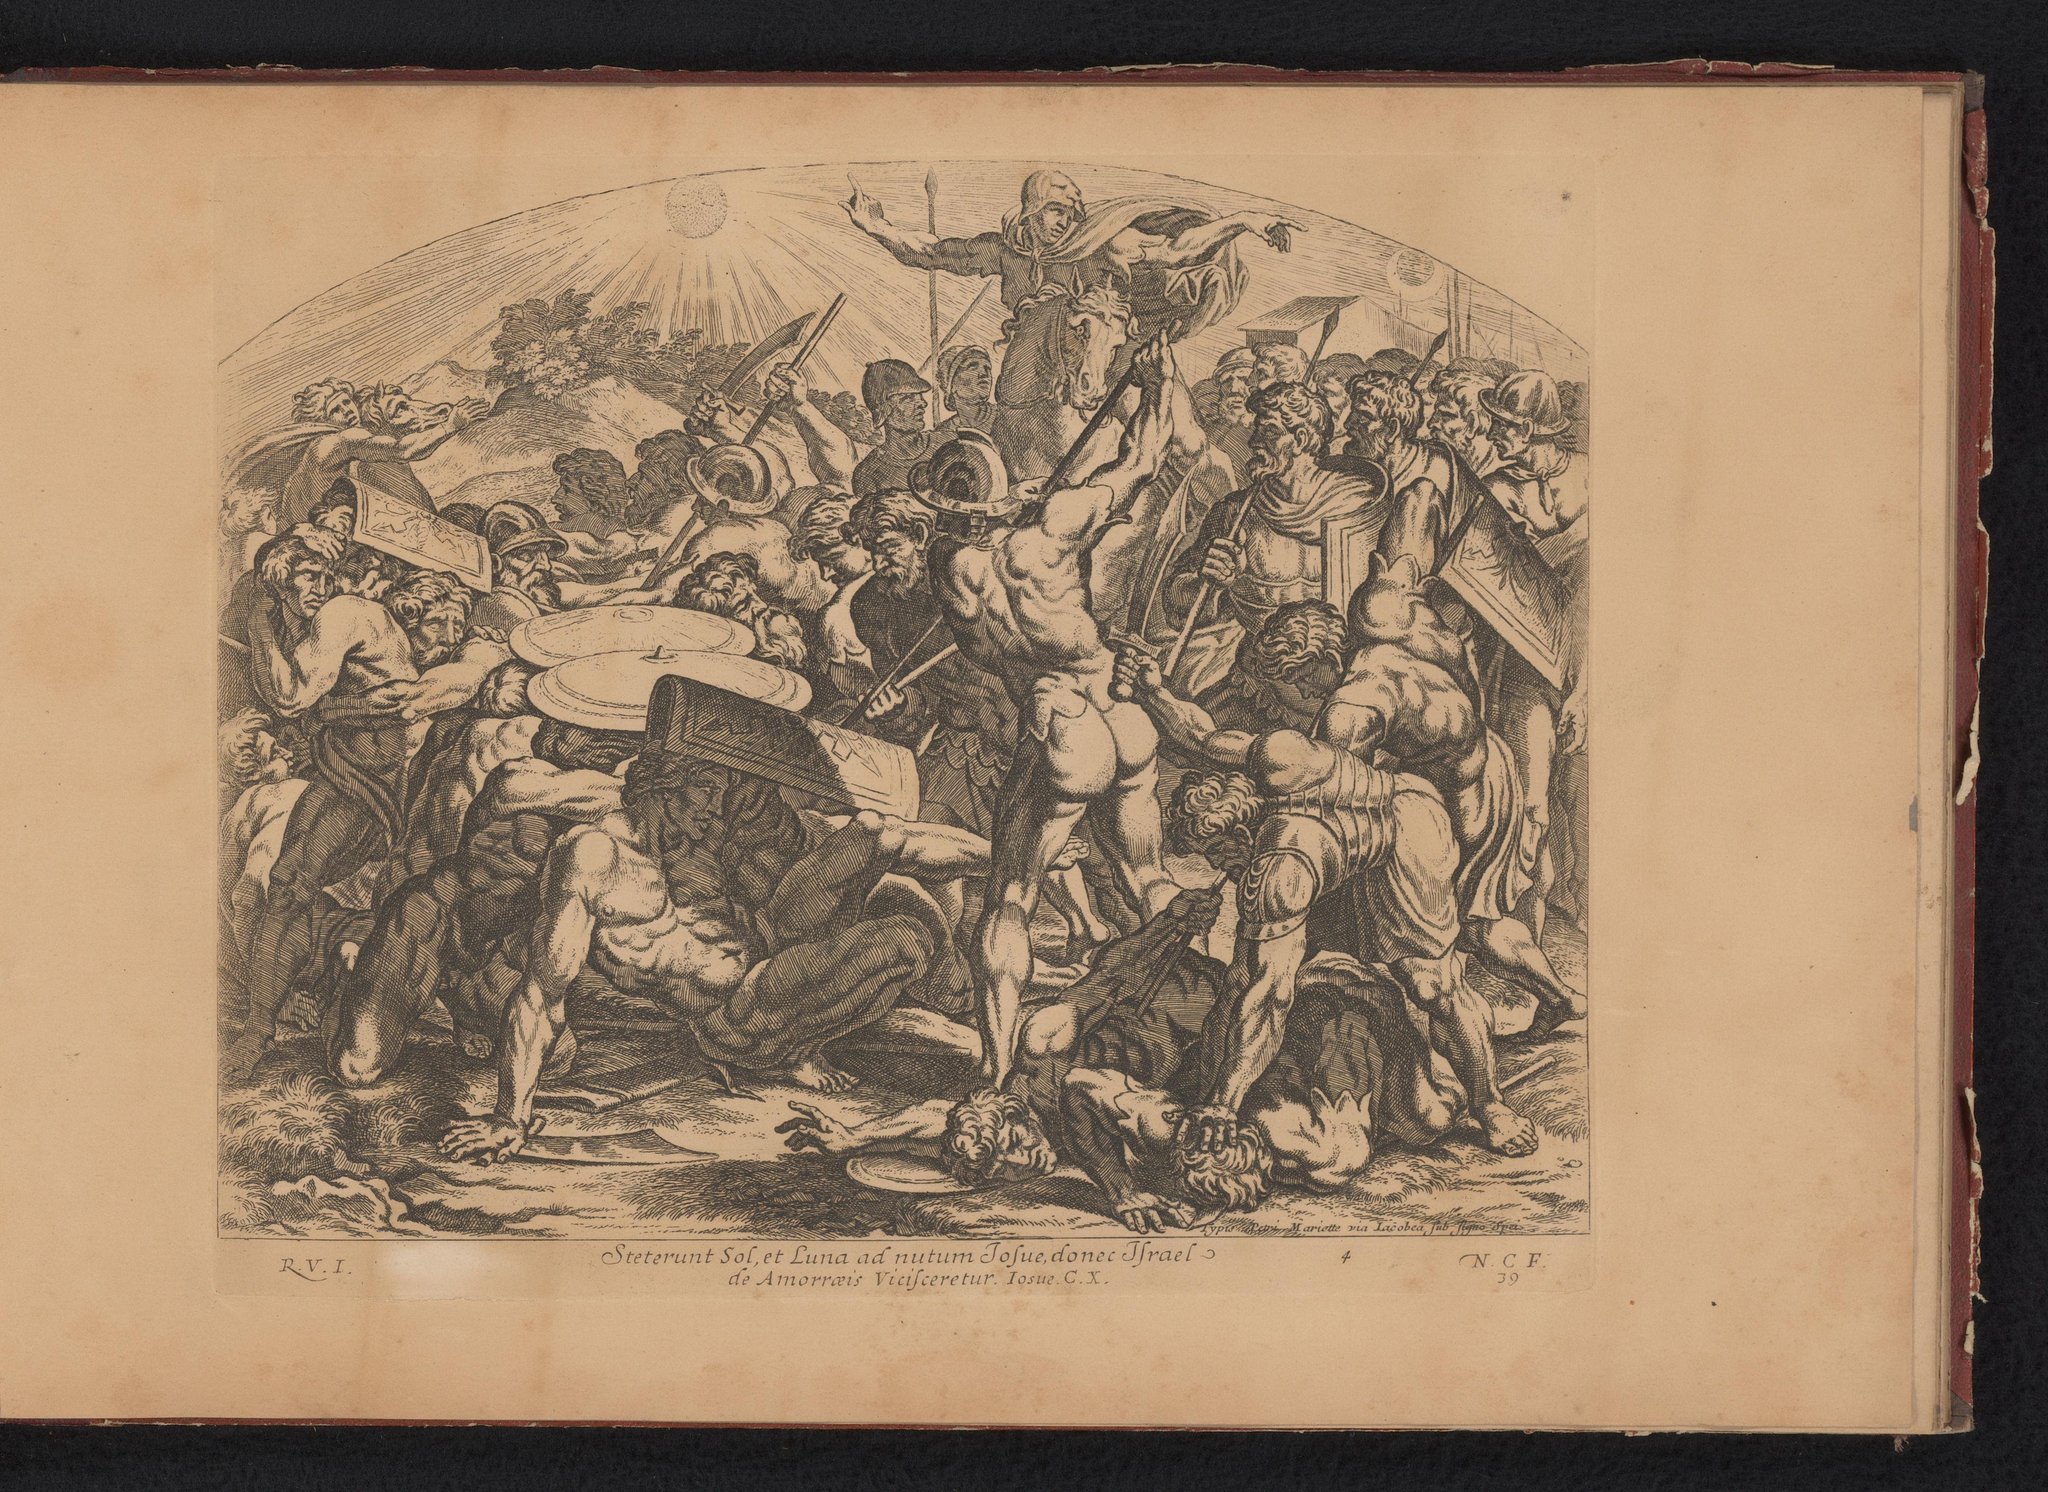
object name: print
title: Rafaël Bijbel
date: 1649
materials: paper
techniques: etching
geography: paris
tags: the fall of jericho (joshua 6), ark of the covenant ~ jewish religion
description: Deze prent maakt deel uit van een album.